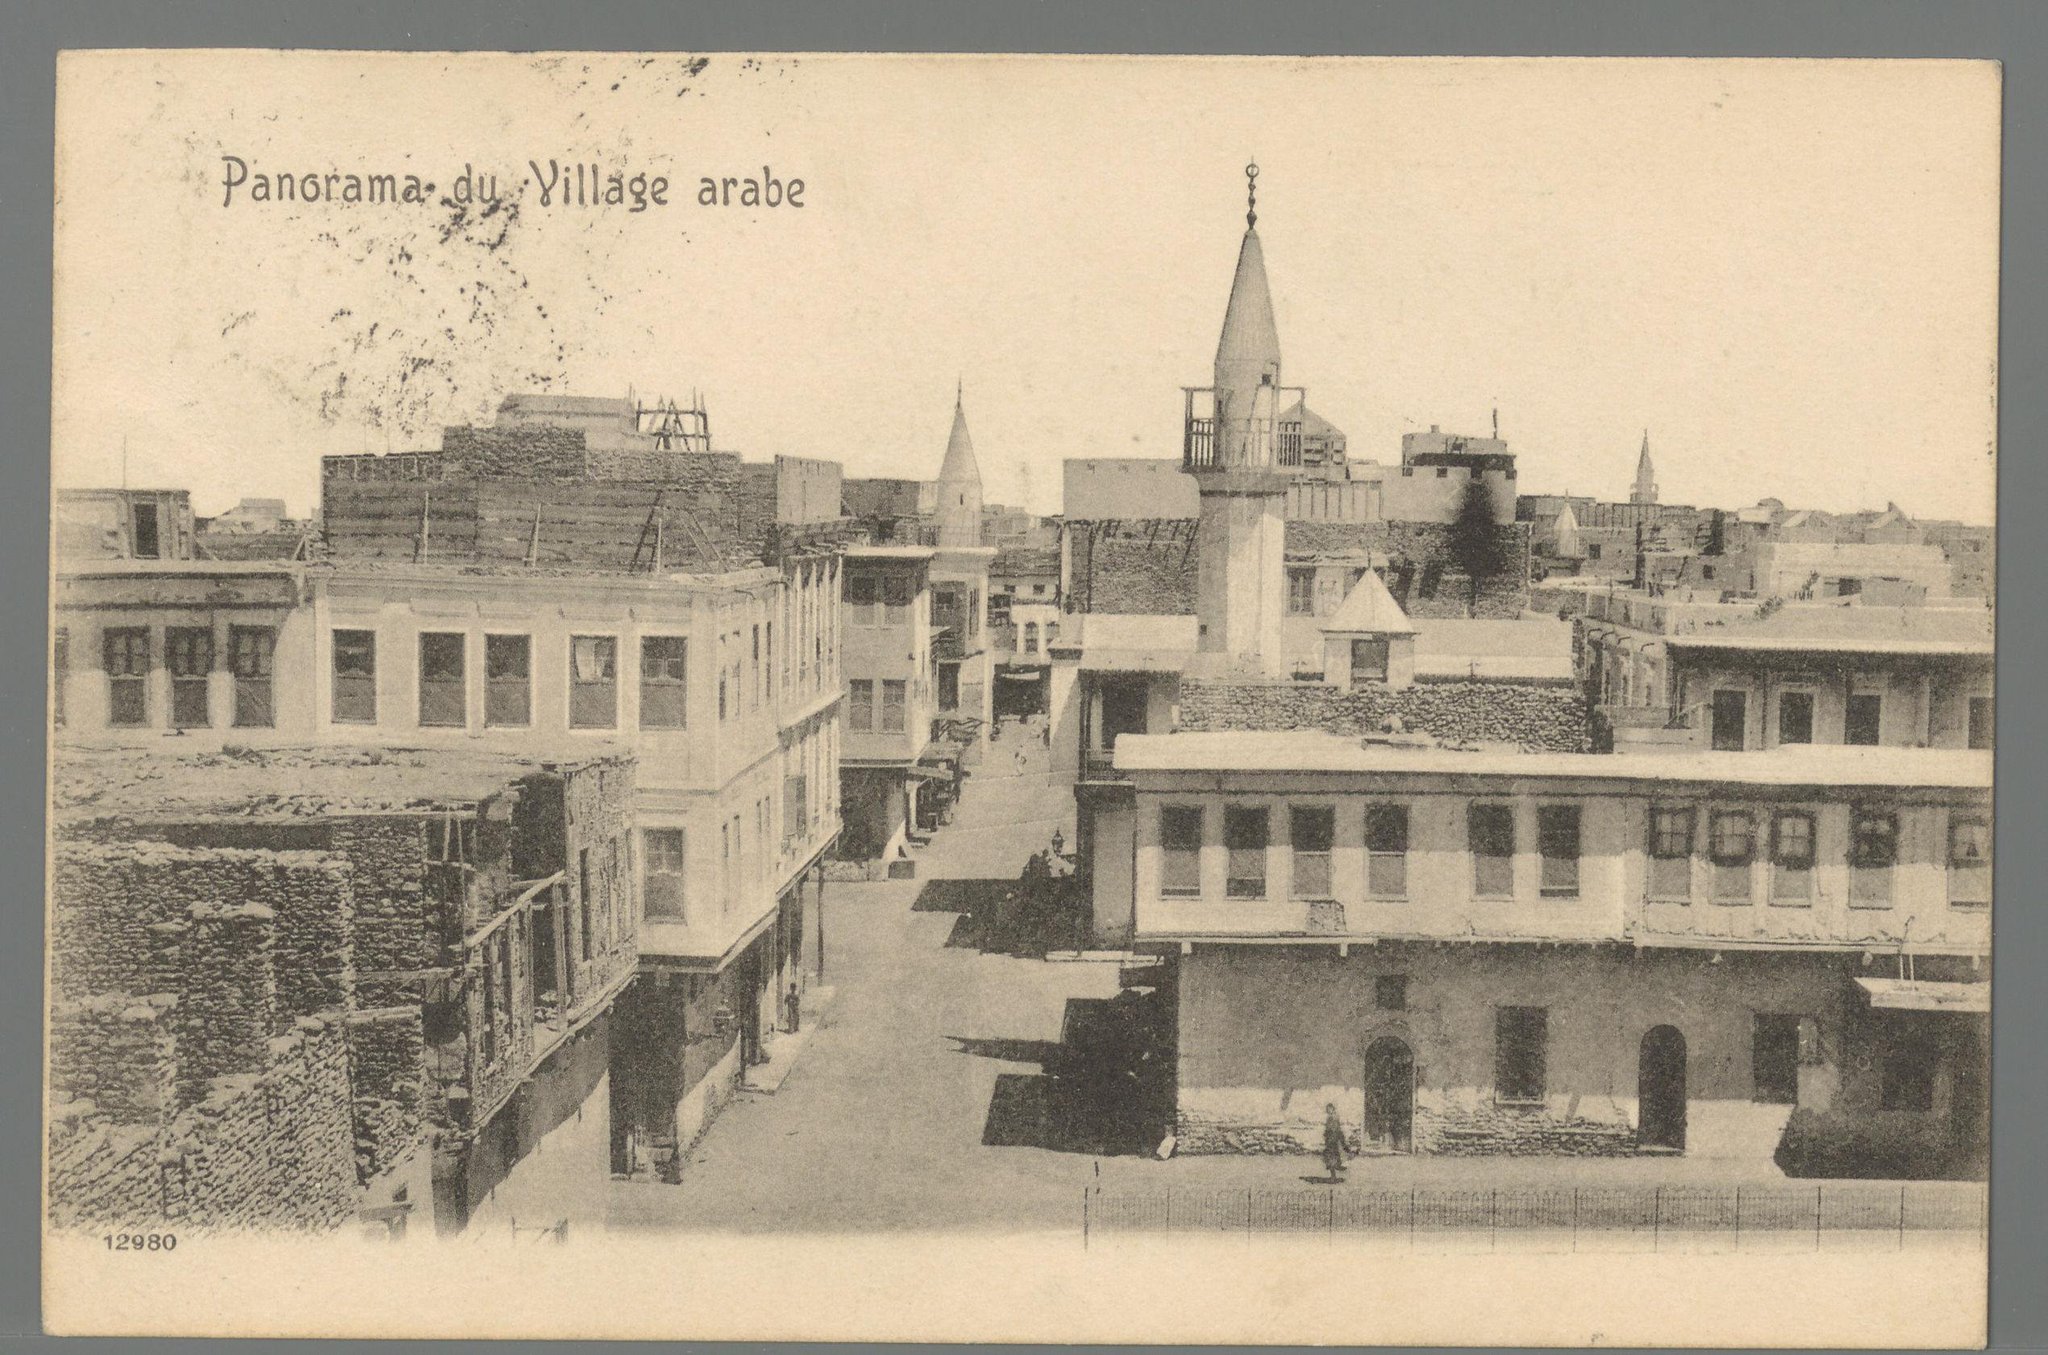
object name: ansichtkaart, prentbriefkaart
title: Panorama du Village arabe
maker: Anonymous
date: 1900-1903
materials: cardboard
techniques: photograph, writing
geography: ismailia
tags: city-view, and landscape with man-made constructions, street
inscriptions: poststempel, verso, gestempeld